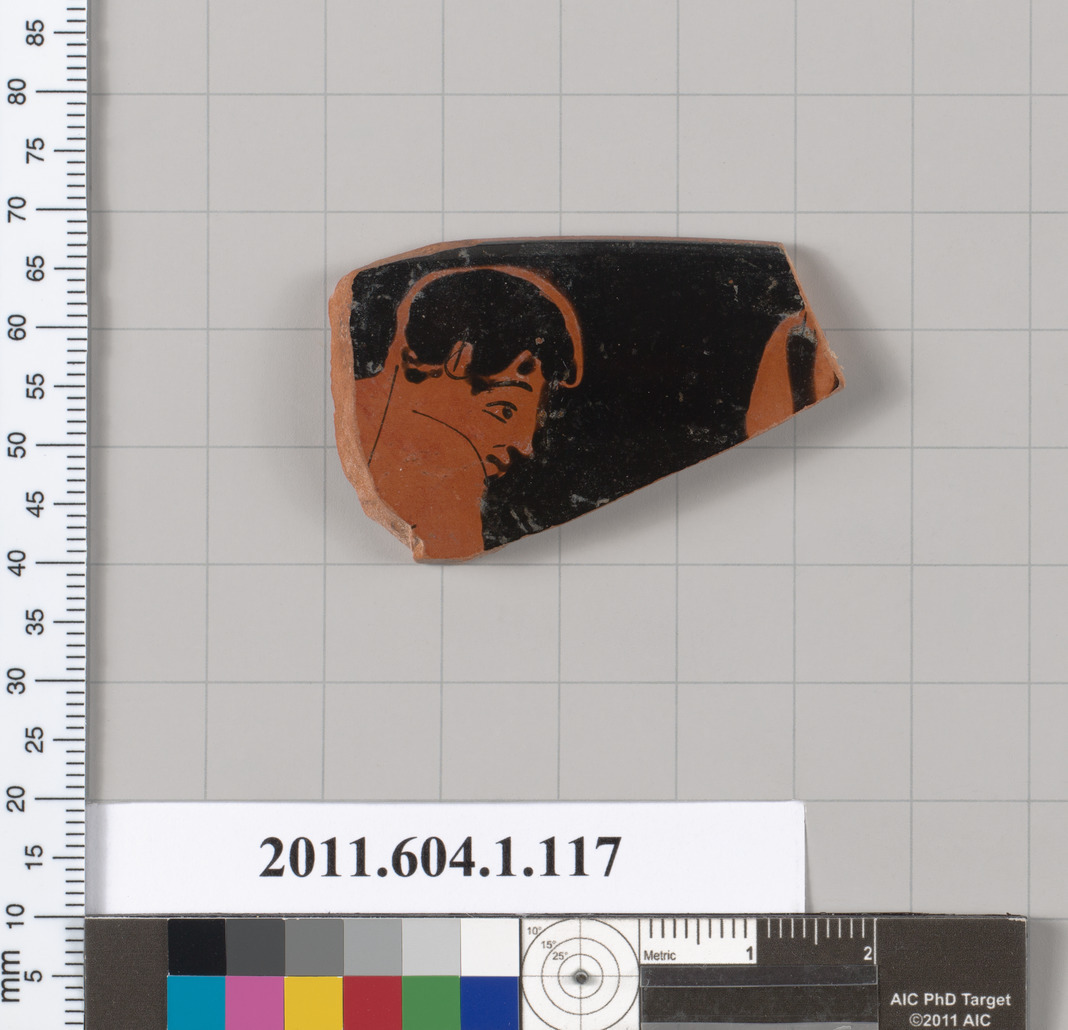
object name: kylix fragment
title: Terracotta rim fragment of a kylix (drinking cup)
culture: greek, attic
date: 470-450 BCE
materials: terracotta